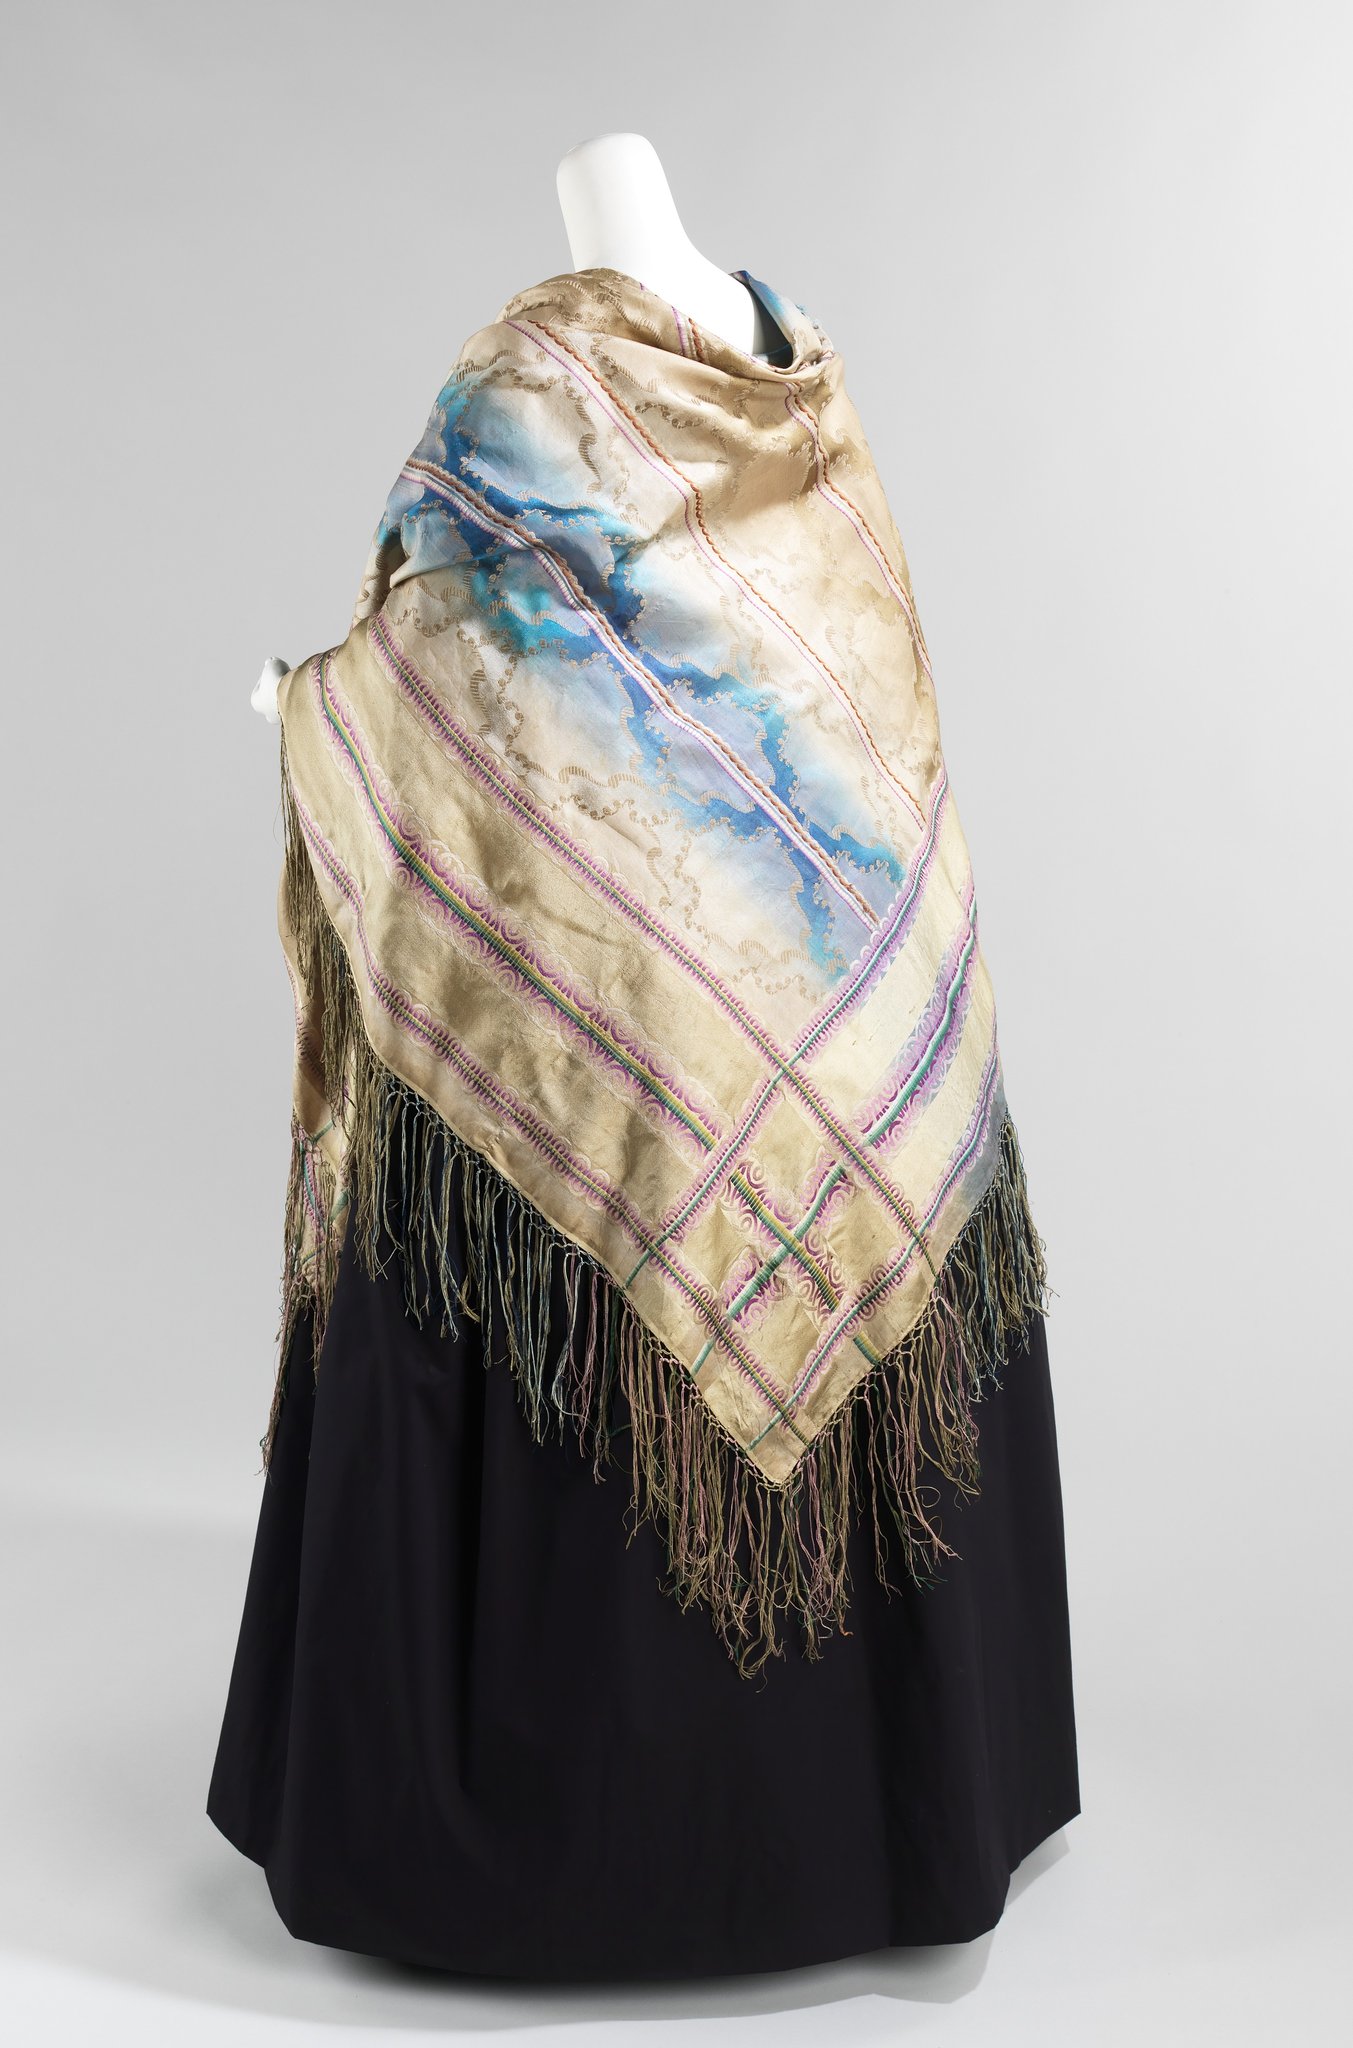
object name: shawl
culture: american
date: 1840-1849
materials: silk